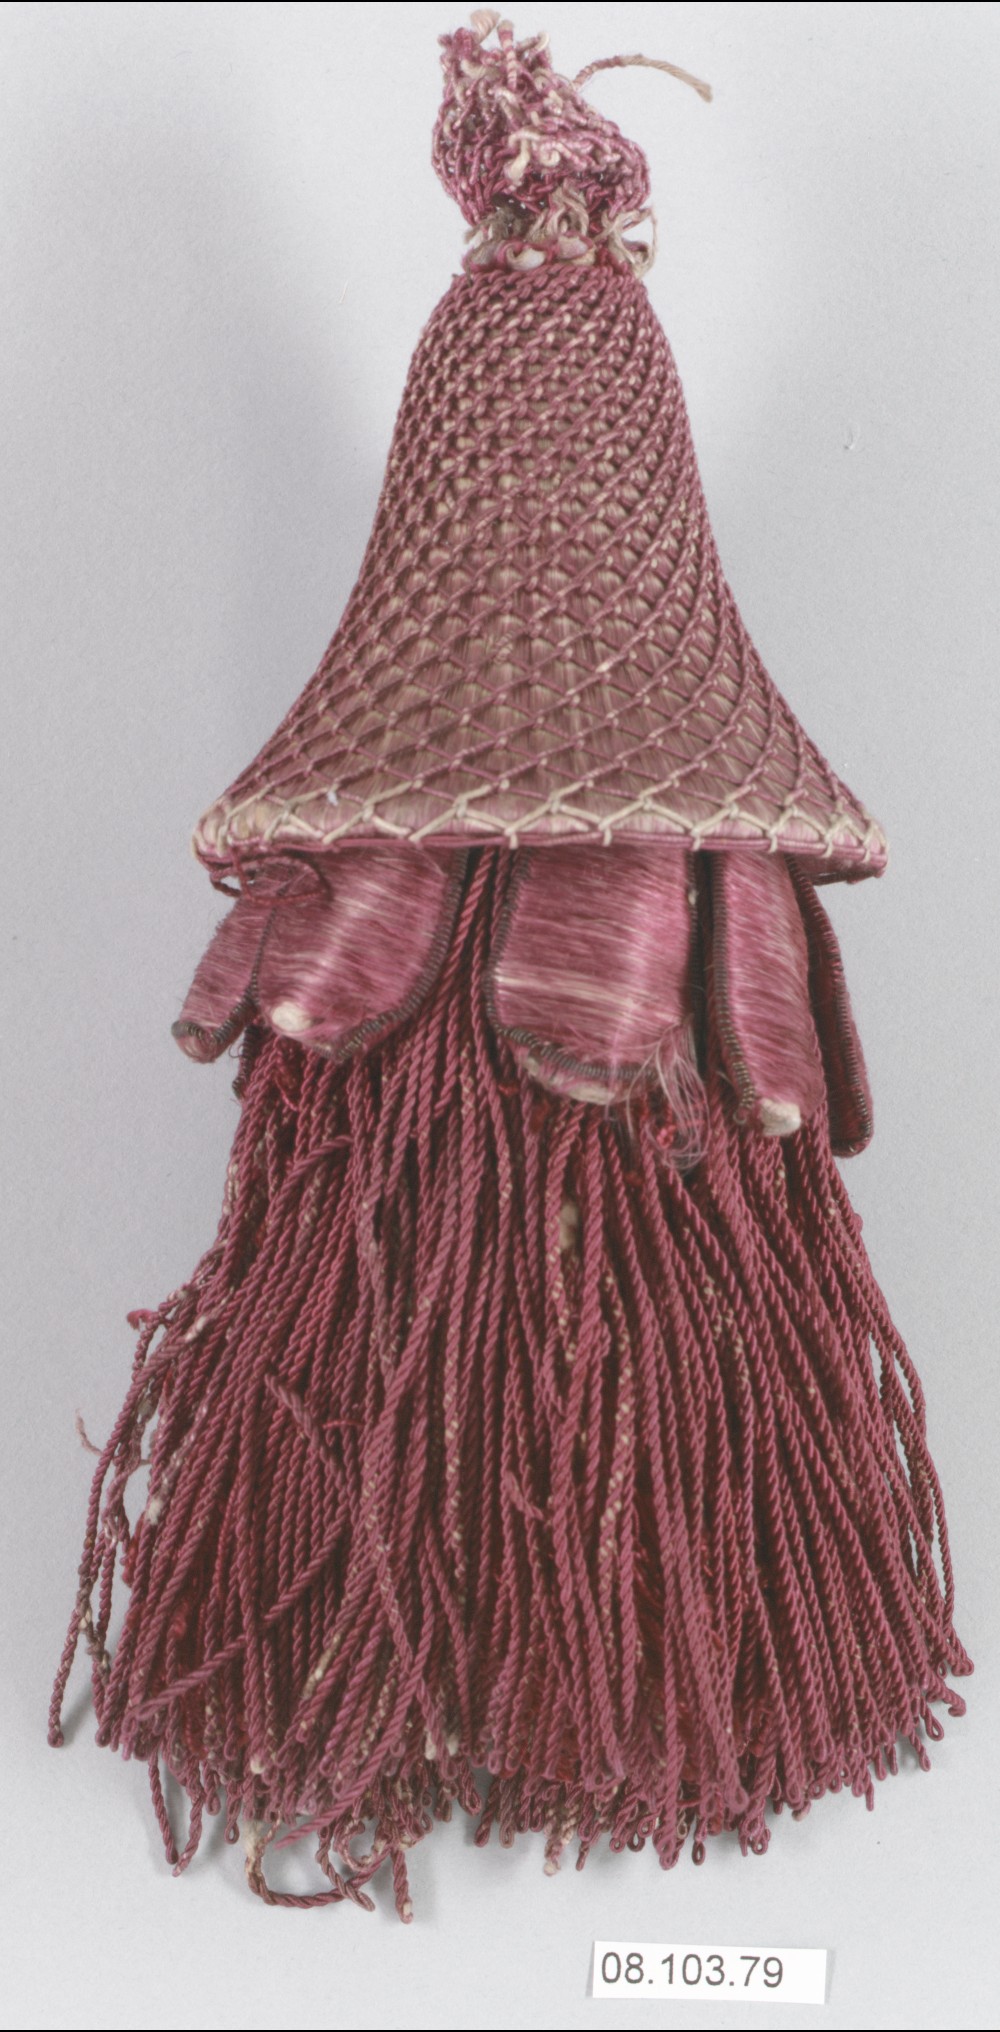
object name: tassel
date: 1701-1800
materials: silk